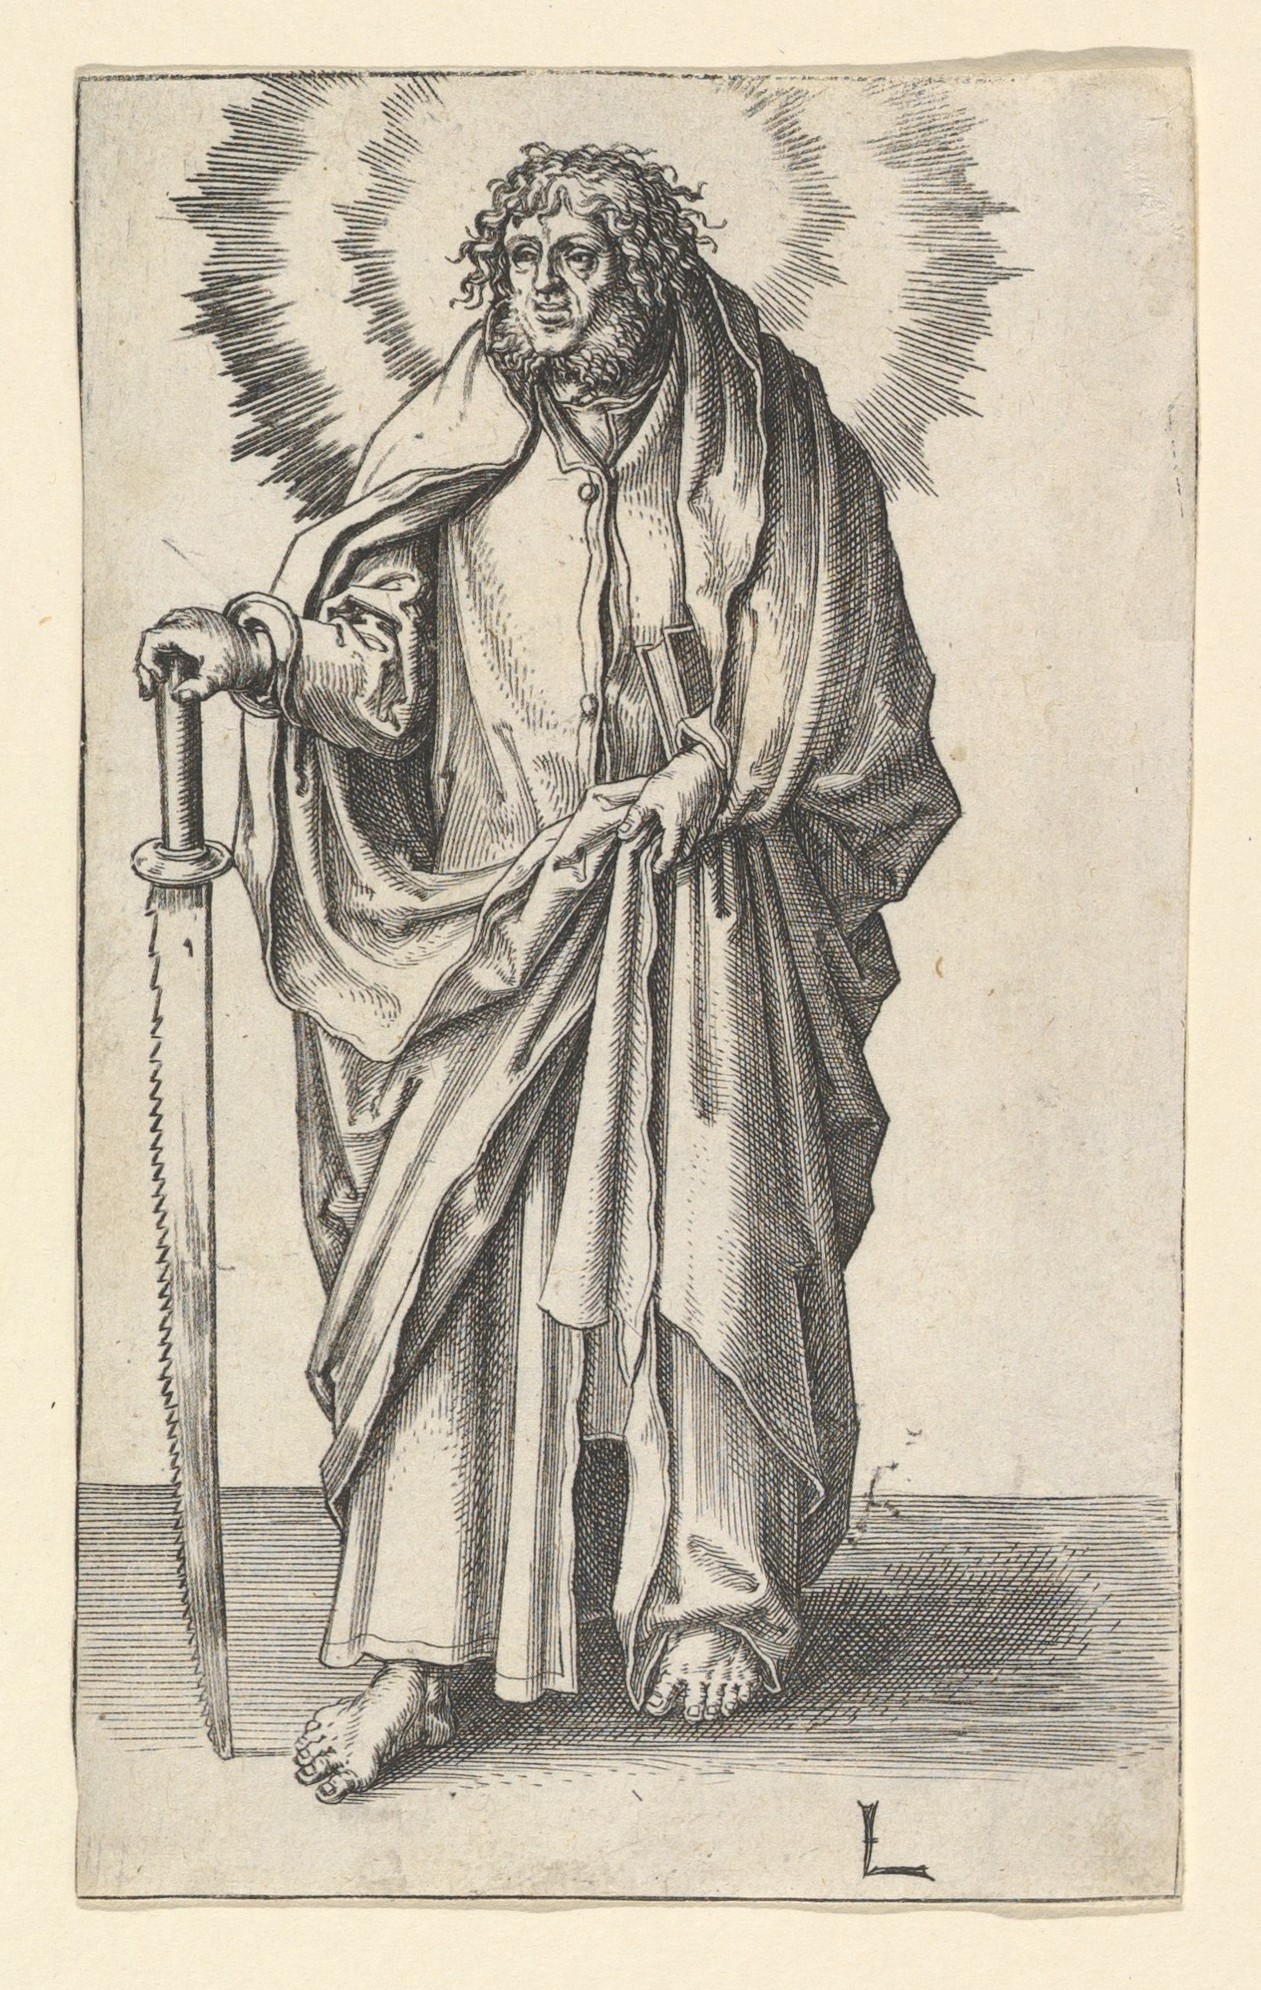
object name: print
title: St. Simon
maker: lucas van leyden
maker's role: artist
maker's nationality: netherlandish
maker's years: 1494-1533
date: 1510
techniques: engraving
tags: swords,men,saints